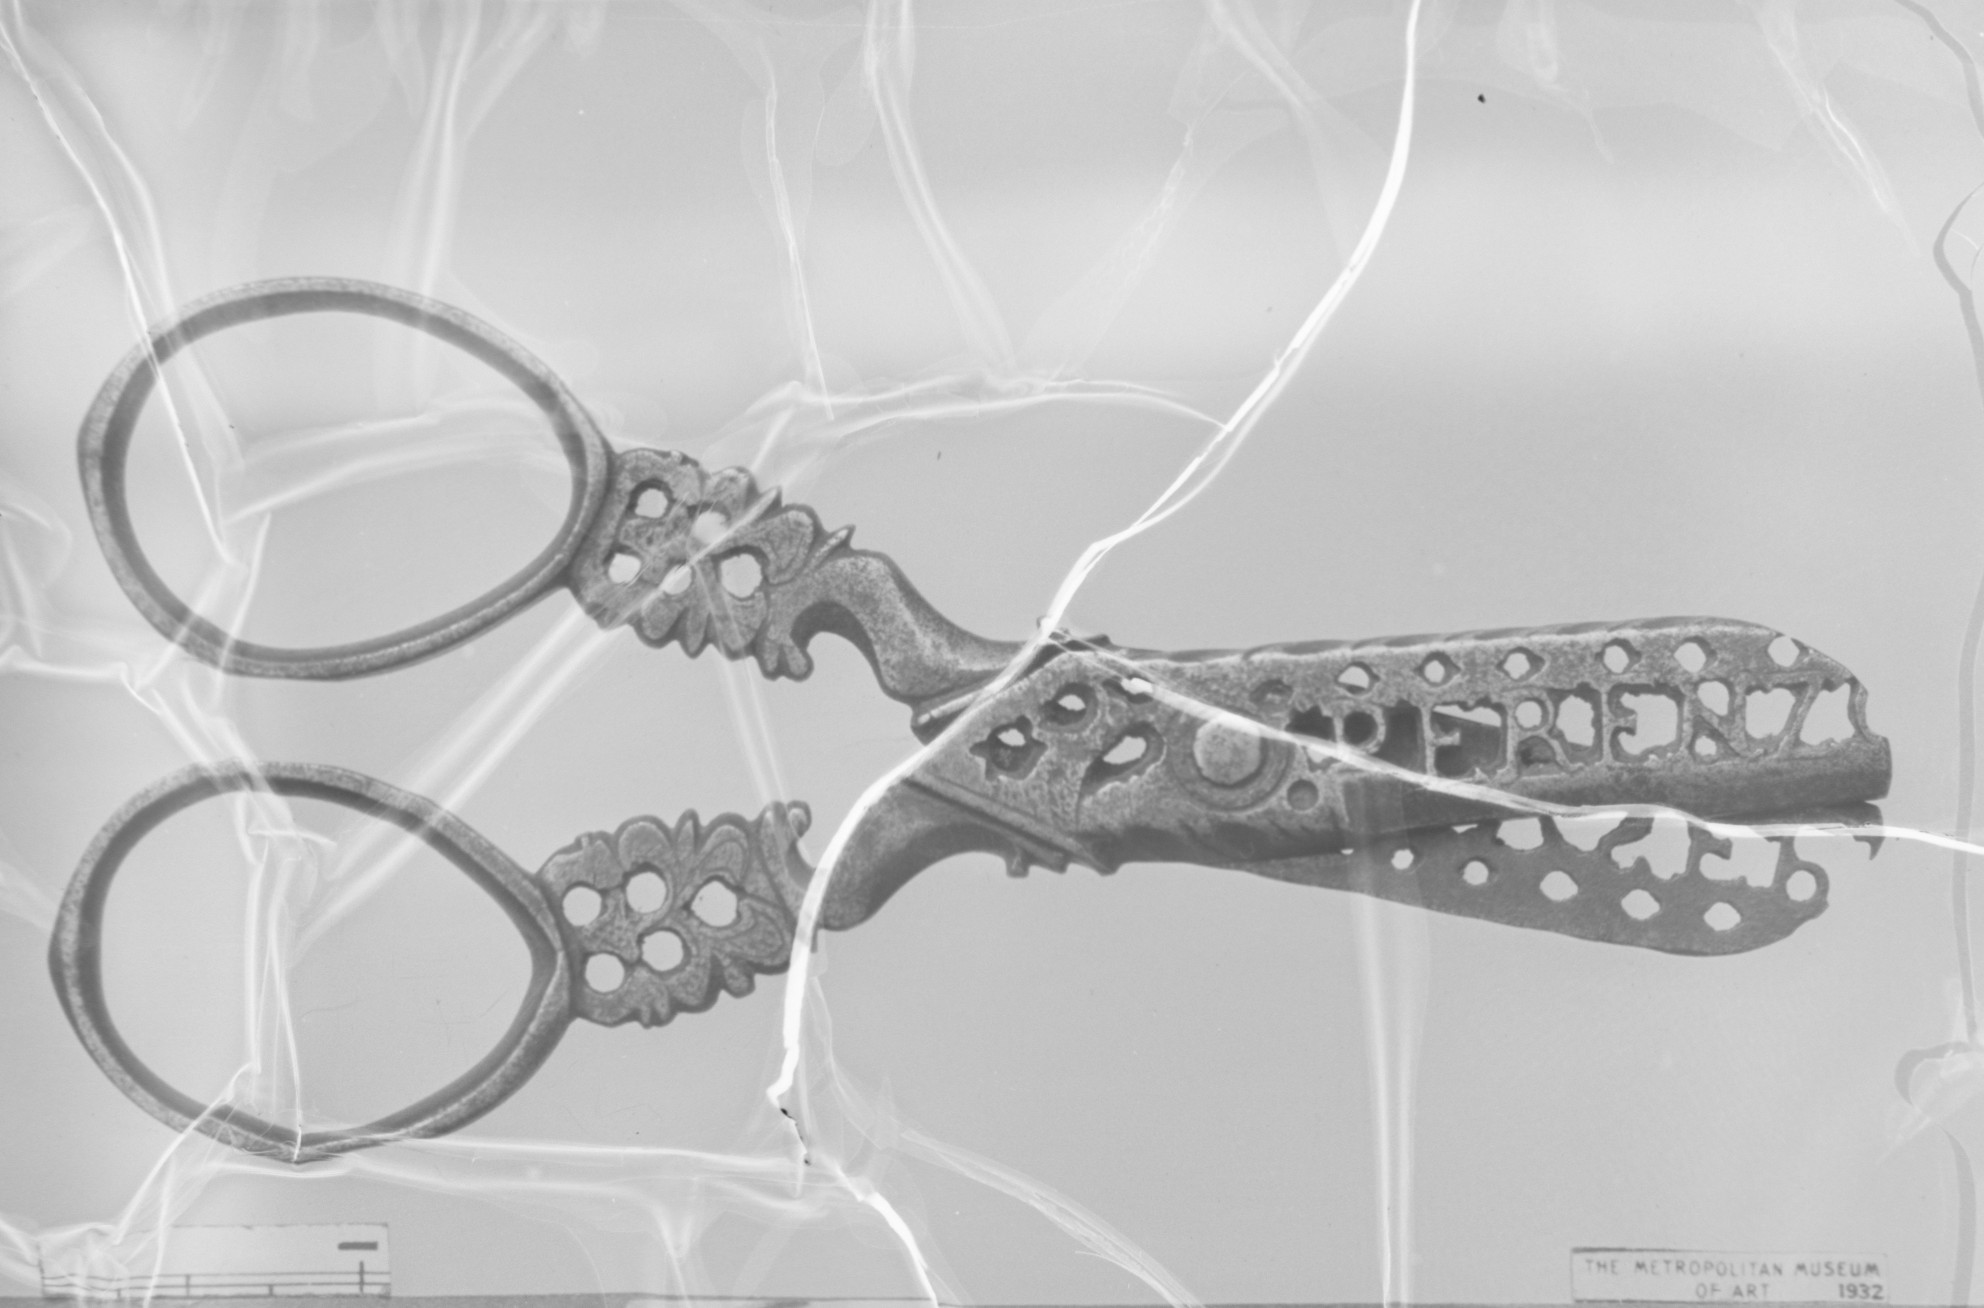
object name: scissors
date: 1601-1700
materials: iron